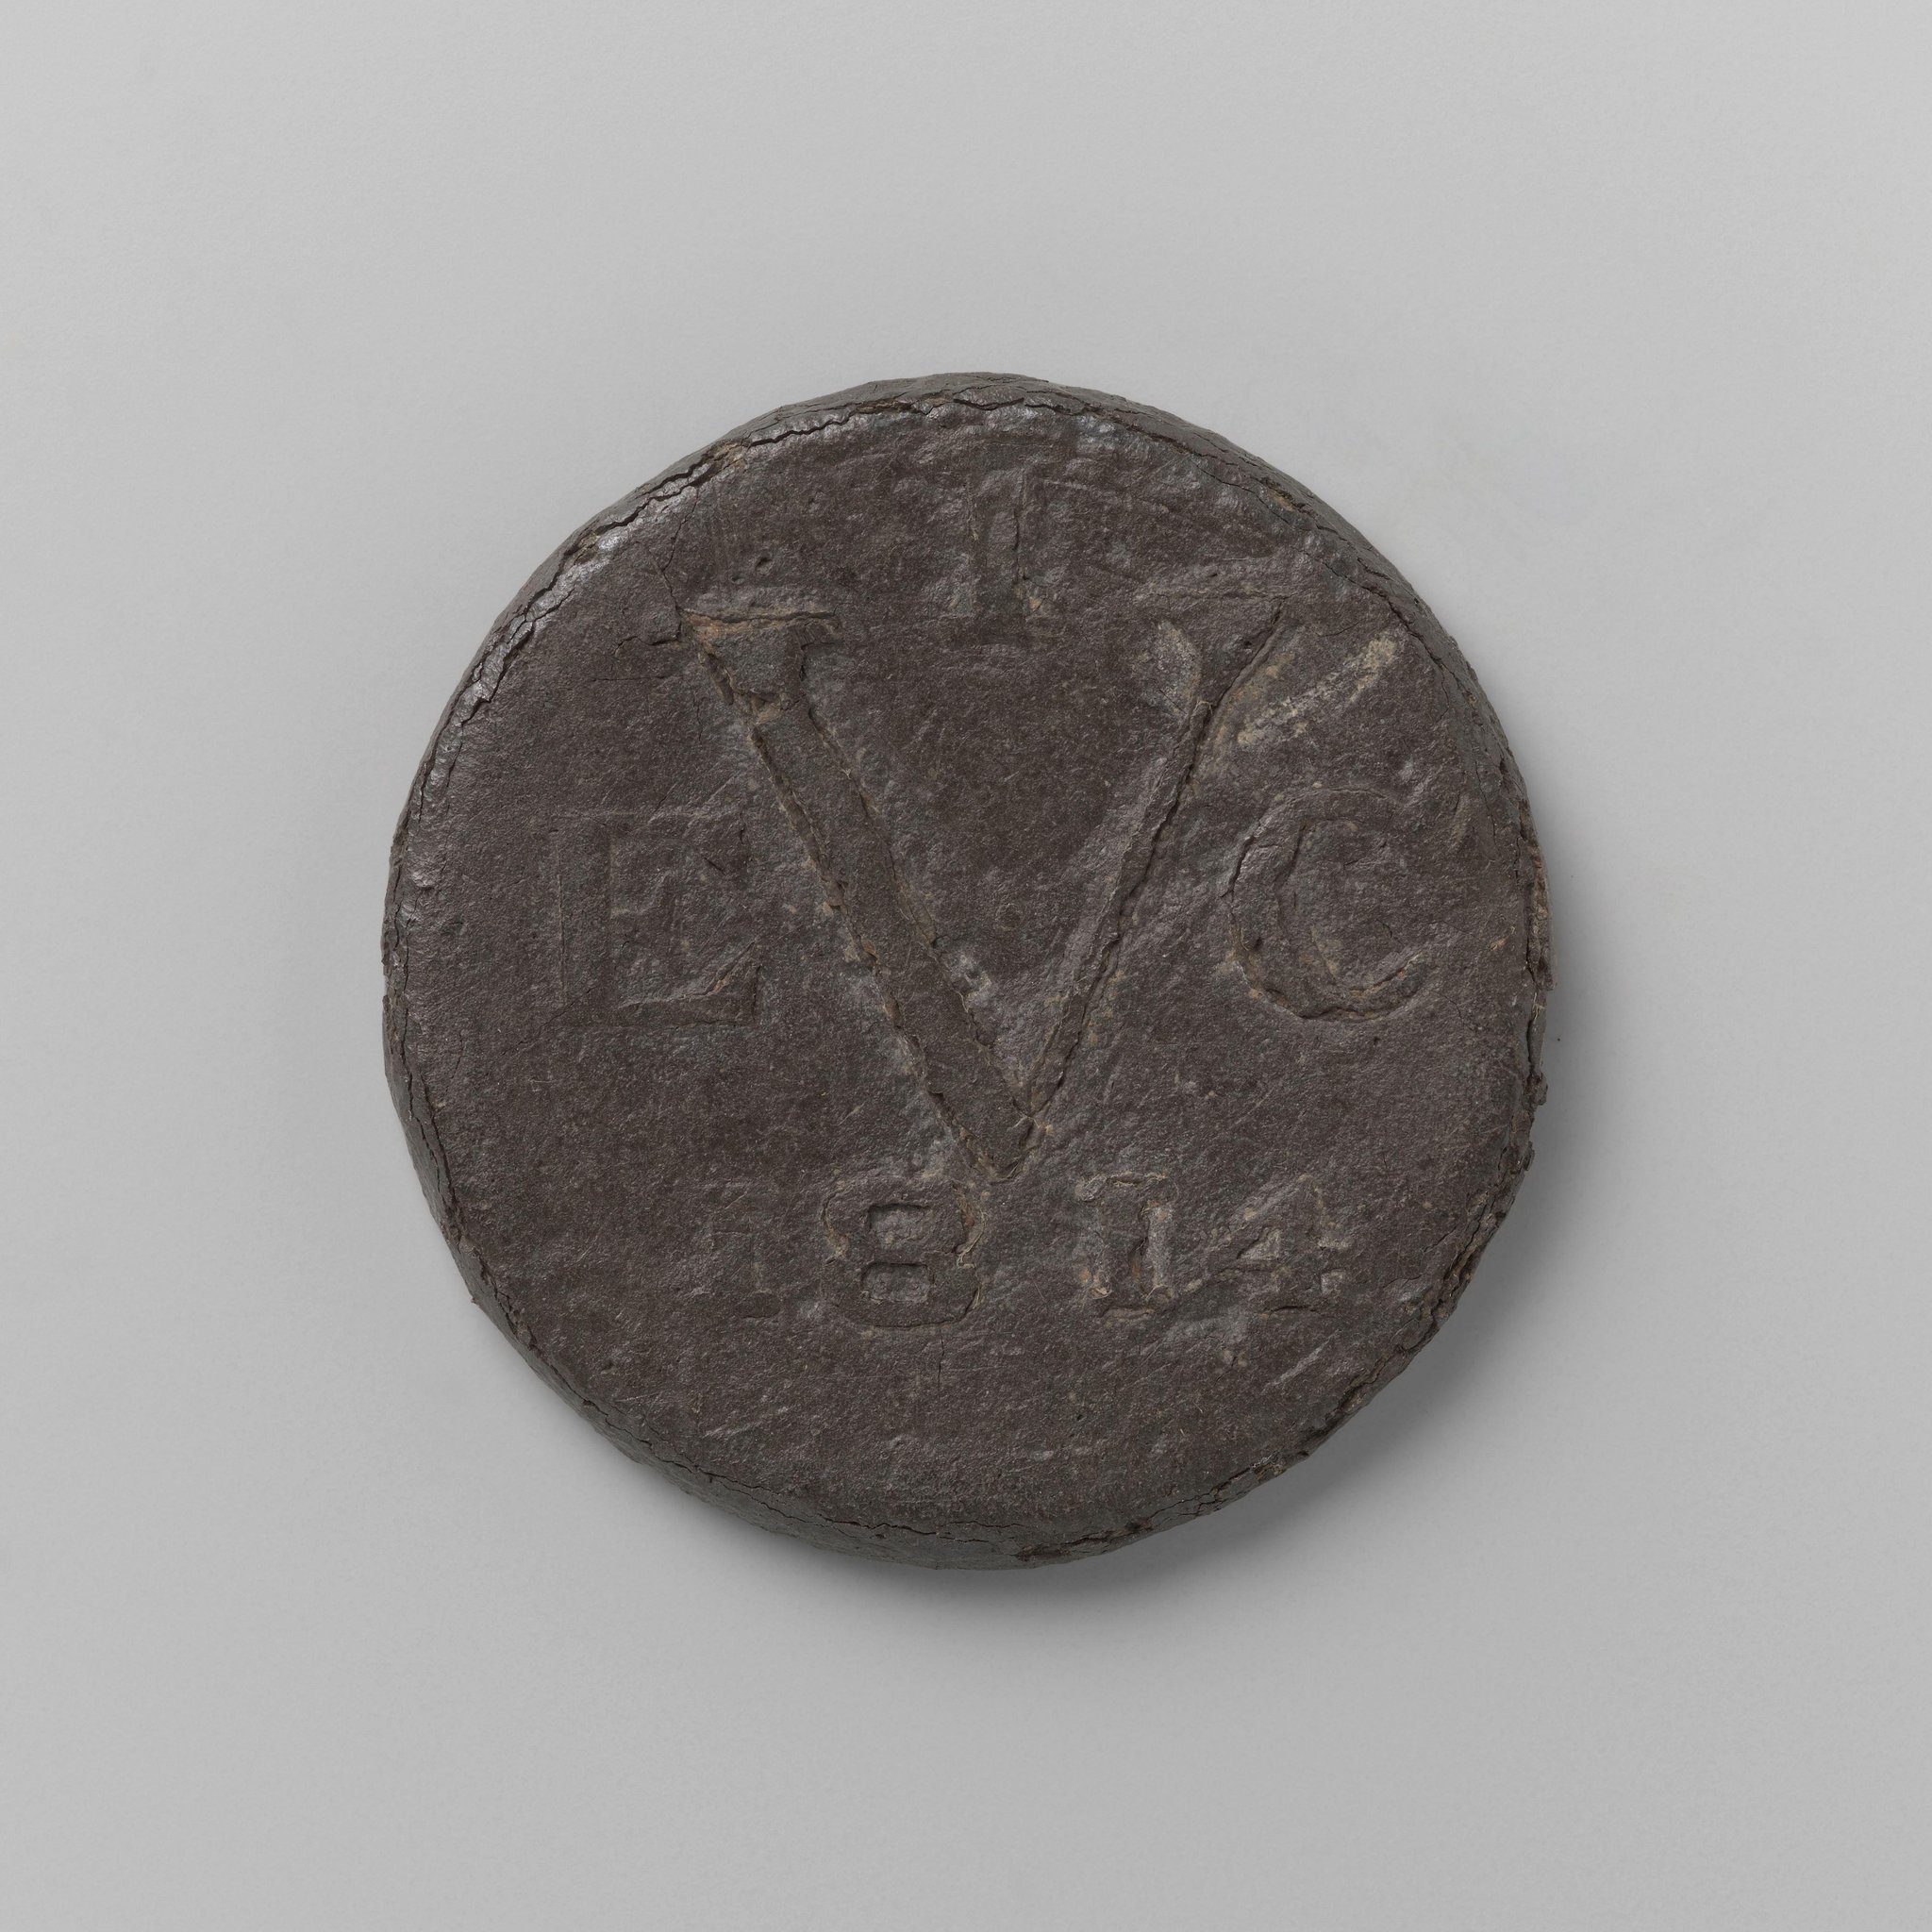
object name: coin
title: Nederlands Indië tijdens Brits bestuur, duit Java,1814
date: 1814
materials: tin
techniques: striking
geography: batavia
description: Tinnen munt. Voorzijde: Letter V tussen letters E en C. Boven deze letters letter I en onder deze letters jaartal. Keerzijde: op twee regels waarde-aanduiding: 1 doit, waaronder opschrift: Java. Daaronder jaartal.